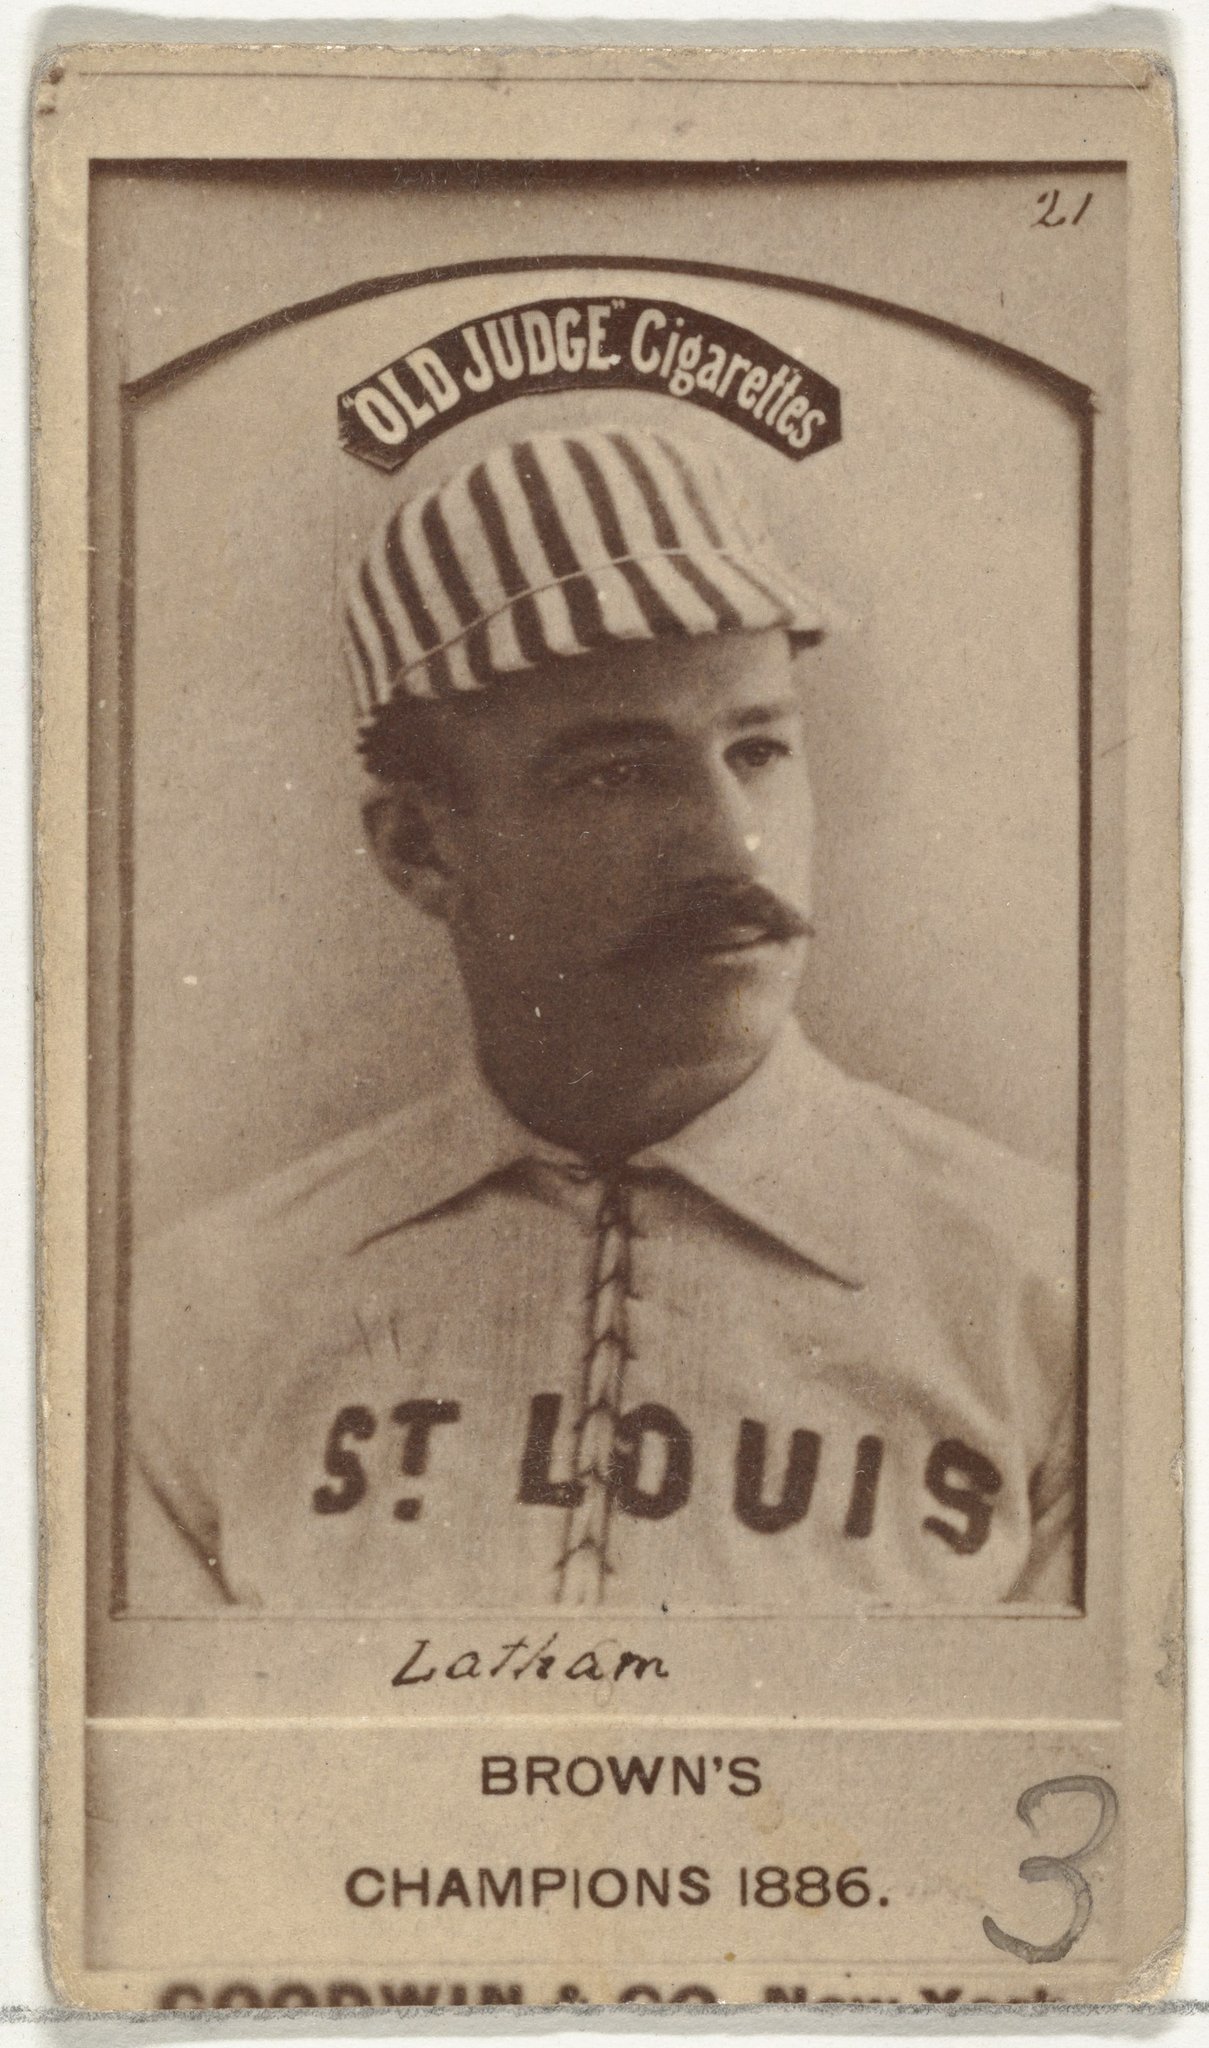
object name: baseball card, photograph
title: Arlie Latham, 3rd Base, St. Louis Browns, from the Old Judge series (N172) for Old Judge Cigarettes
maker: goodwin & company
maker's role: publisher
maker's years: 1850-1950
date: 1887-1890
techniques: albumen silver print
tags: men,portraits,baseball,athletes